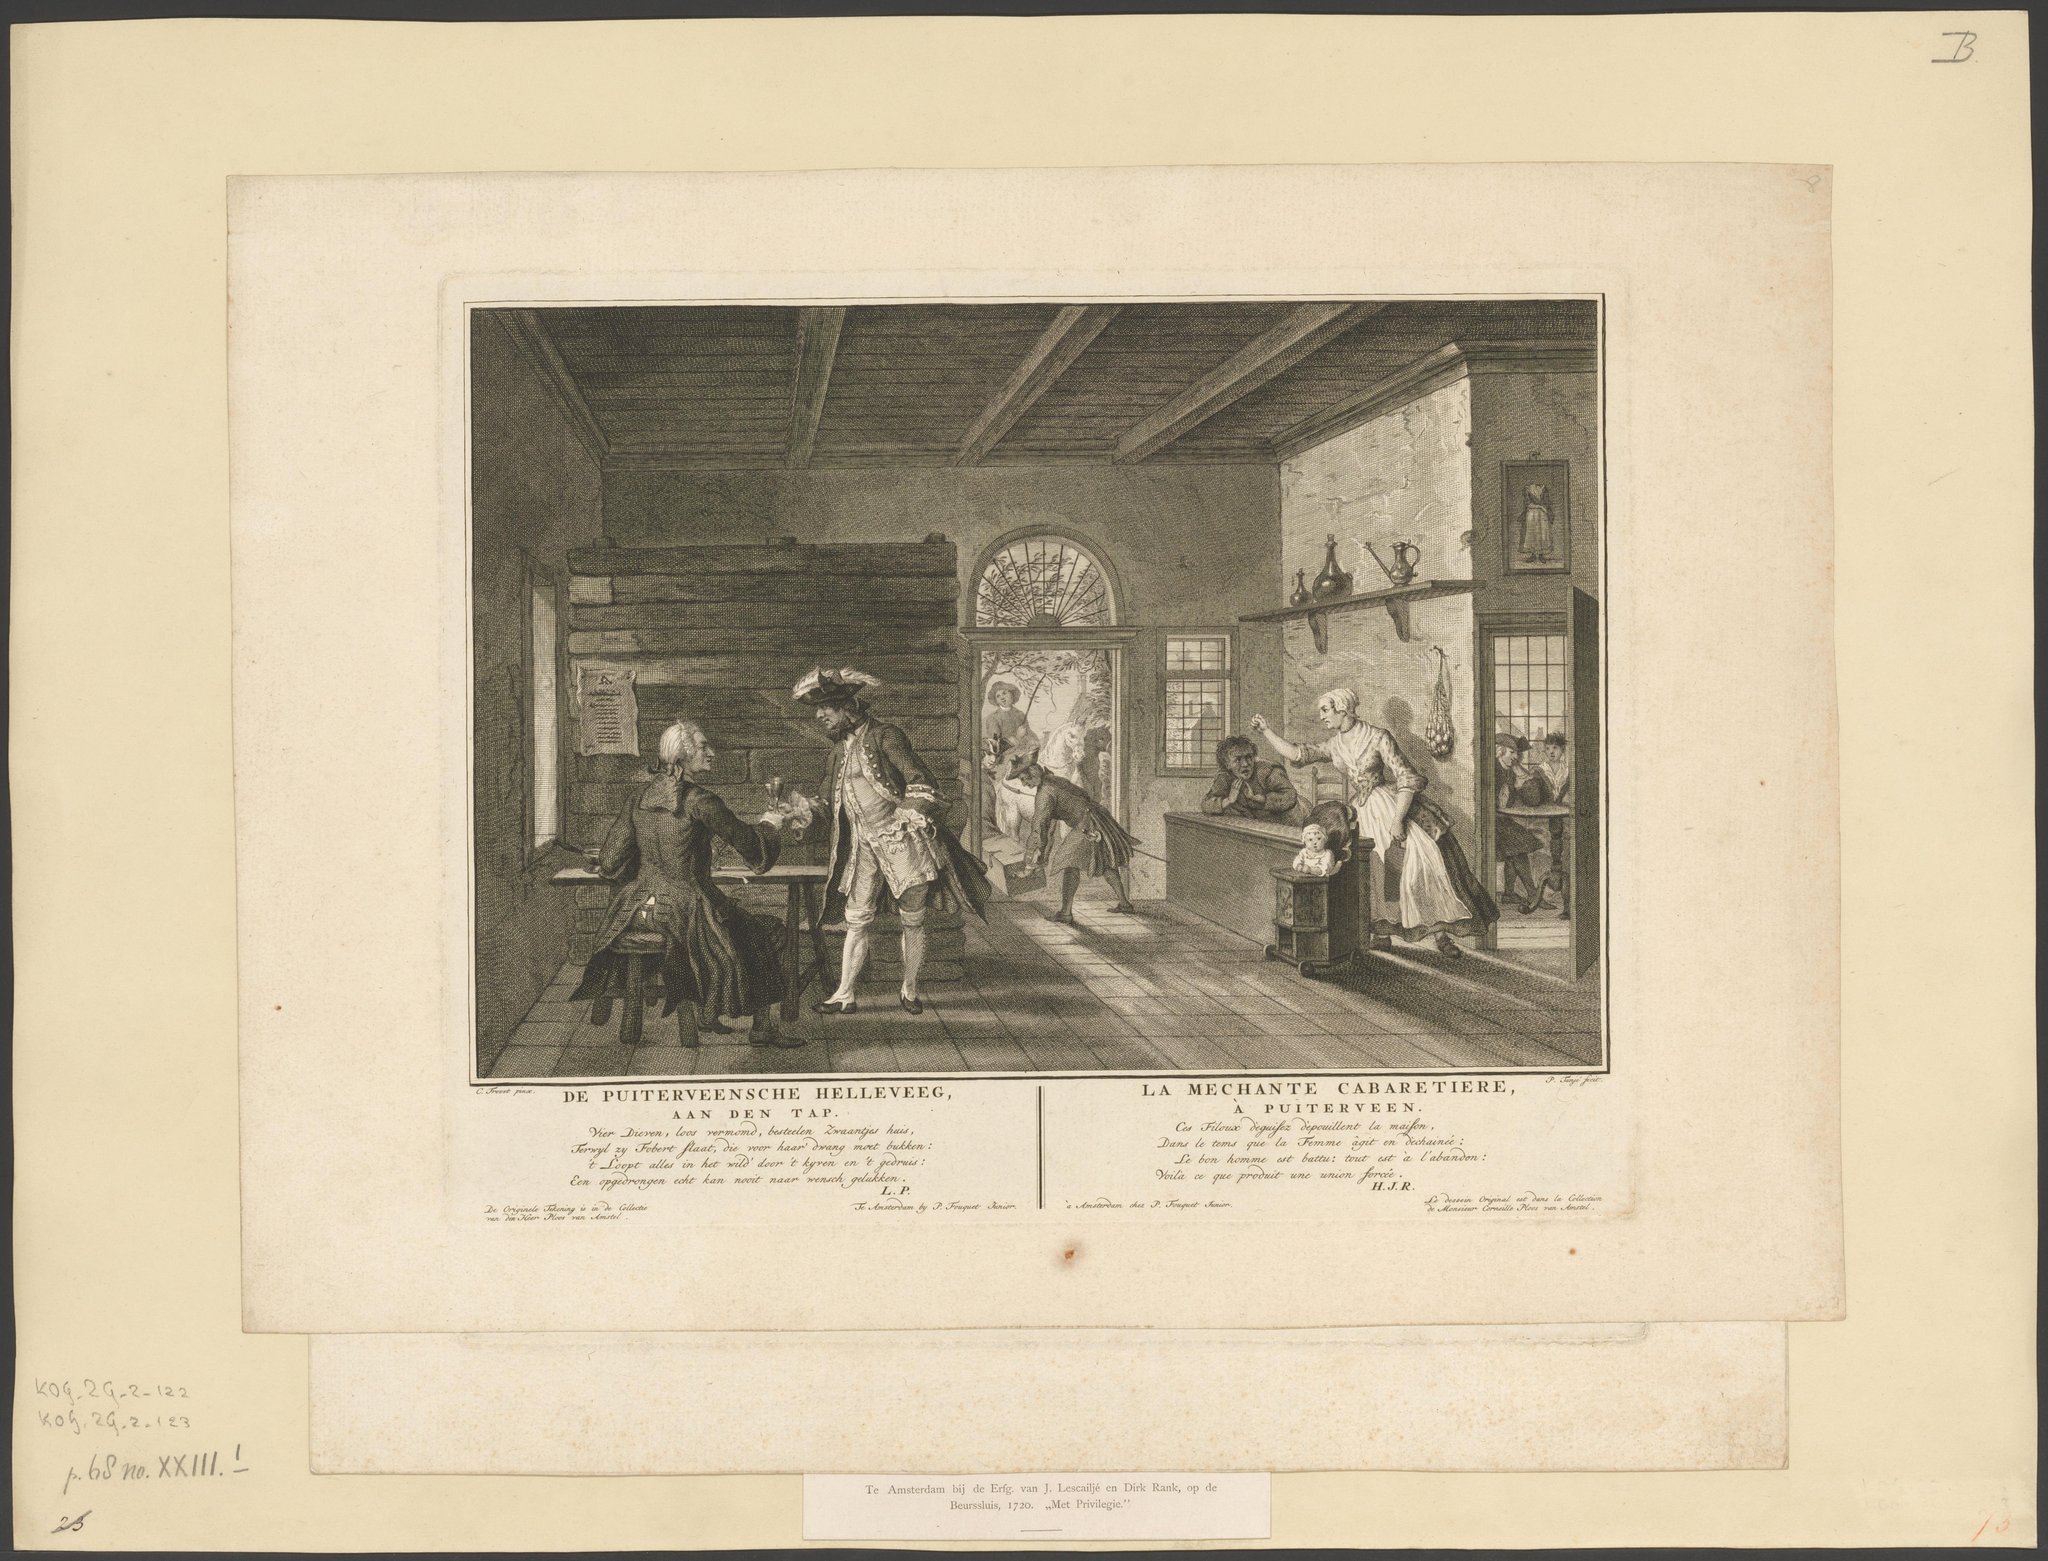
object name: print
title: De Puiterveensche helleveeg, aan den tap / La Mechante cabaretiere, à Puiterveen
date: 1754-1764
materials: paper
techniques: engraving, etching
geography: amsterdam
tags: inn, coffee-house, public house, etc., dominating wife, drinking, satire on marriage, comedy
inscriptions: collector's mark: Lugt 2488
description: De verklede dieven Jan de Rolder en Piet Pothuis heffen het glas in de gelagkamer, waar Swaantje achter de tapkast tegen haar man Fobert staat te tieren. Ze is daar zo druk mee, dat ze niet door heeft dat ze wordt bestolen. In de zijkamer rechts zitten Hartje Spilpenning en Saartje van Lichten gekleed als doopsgezinden. Onderaan in de marge een vierregelig vers in het Nederlands en het Frans. Scène uit het tweede bedrijf van het toneelstuk De Puiterveense helleveeg, of Beslikte Swaantje aan den tap, van Abraham Alewijn.